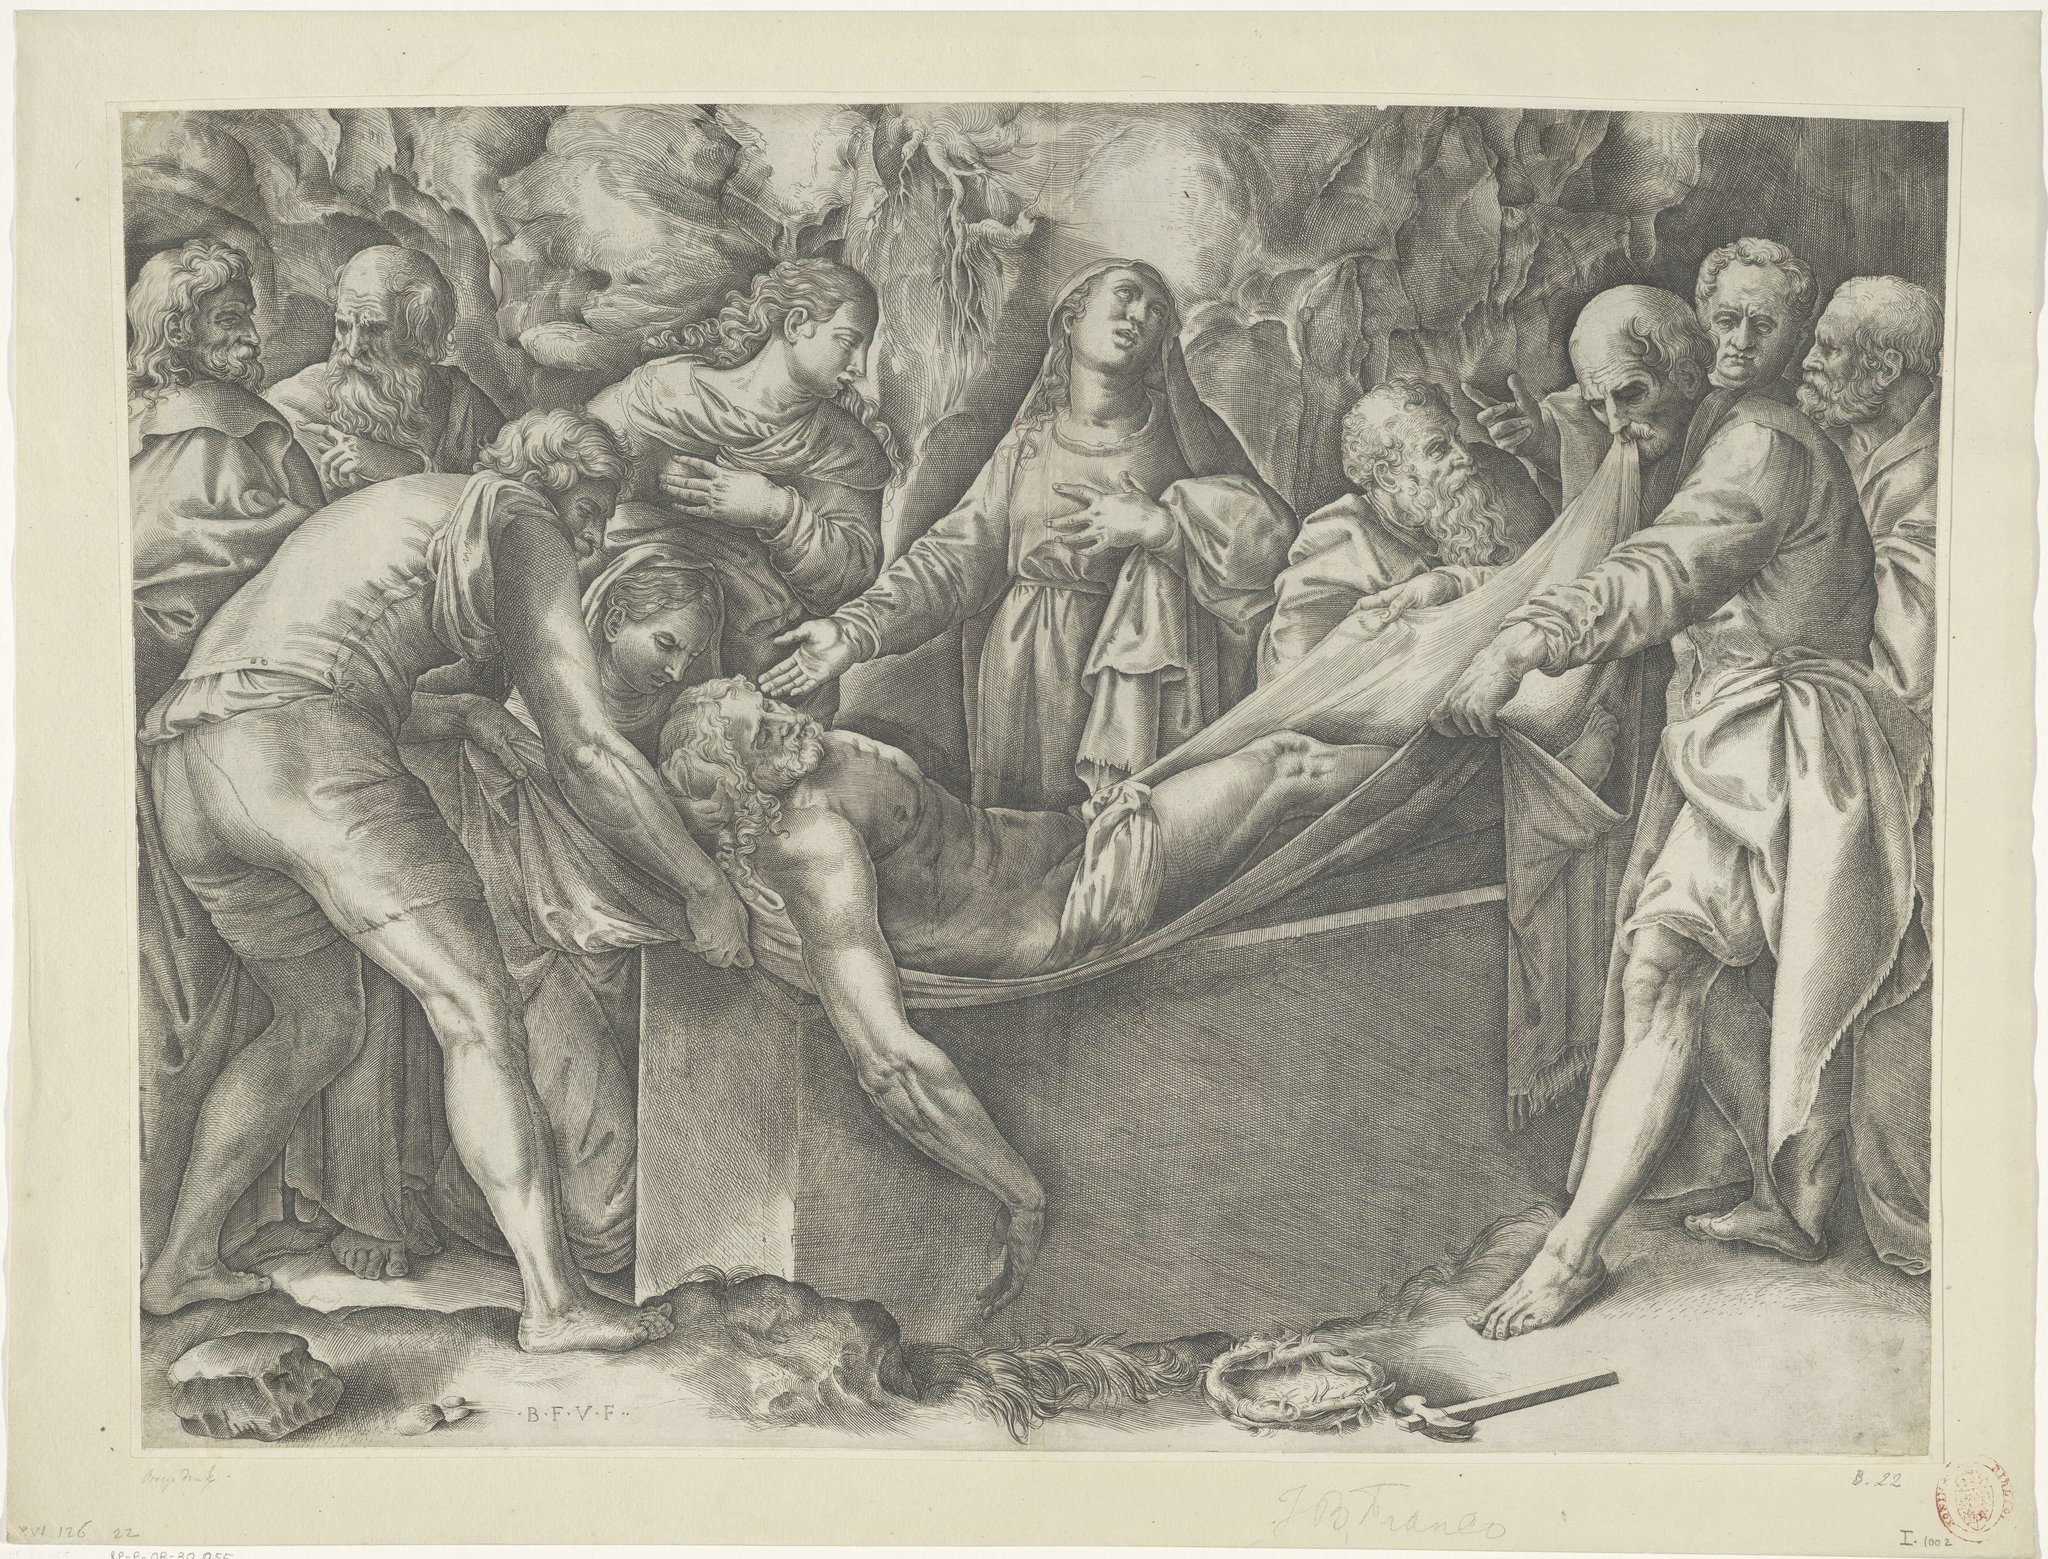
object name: print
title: Graflegging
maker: battista franco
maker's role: draughtsman, painter, print maker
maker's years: 1510-1561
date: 1508-1561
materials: paper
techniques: engraving, etching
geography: venice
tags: christ's entombment (possibly by angels)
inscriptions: collector's mark: Lugt 240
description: Het dode lichaam van Christus wordt door Jozef van Arimatea en Nikodemus met een doek in het graf gelegd. Maria en Johannes de Evangelist staan achter het graf. Maria Magdalena knielt naast het graf. Andere mannen kijken toe.